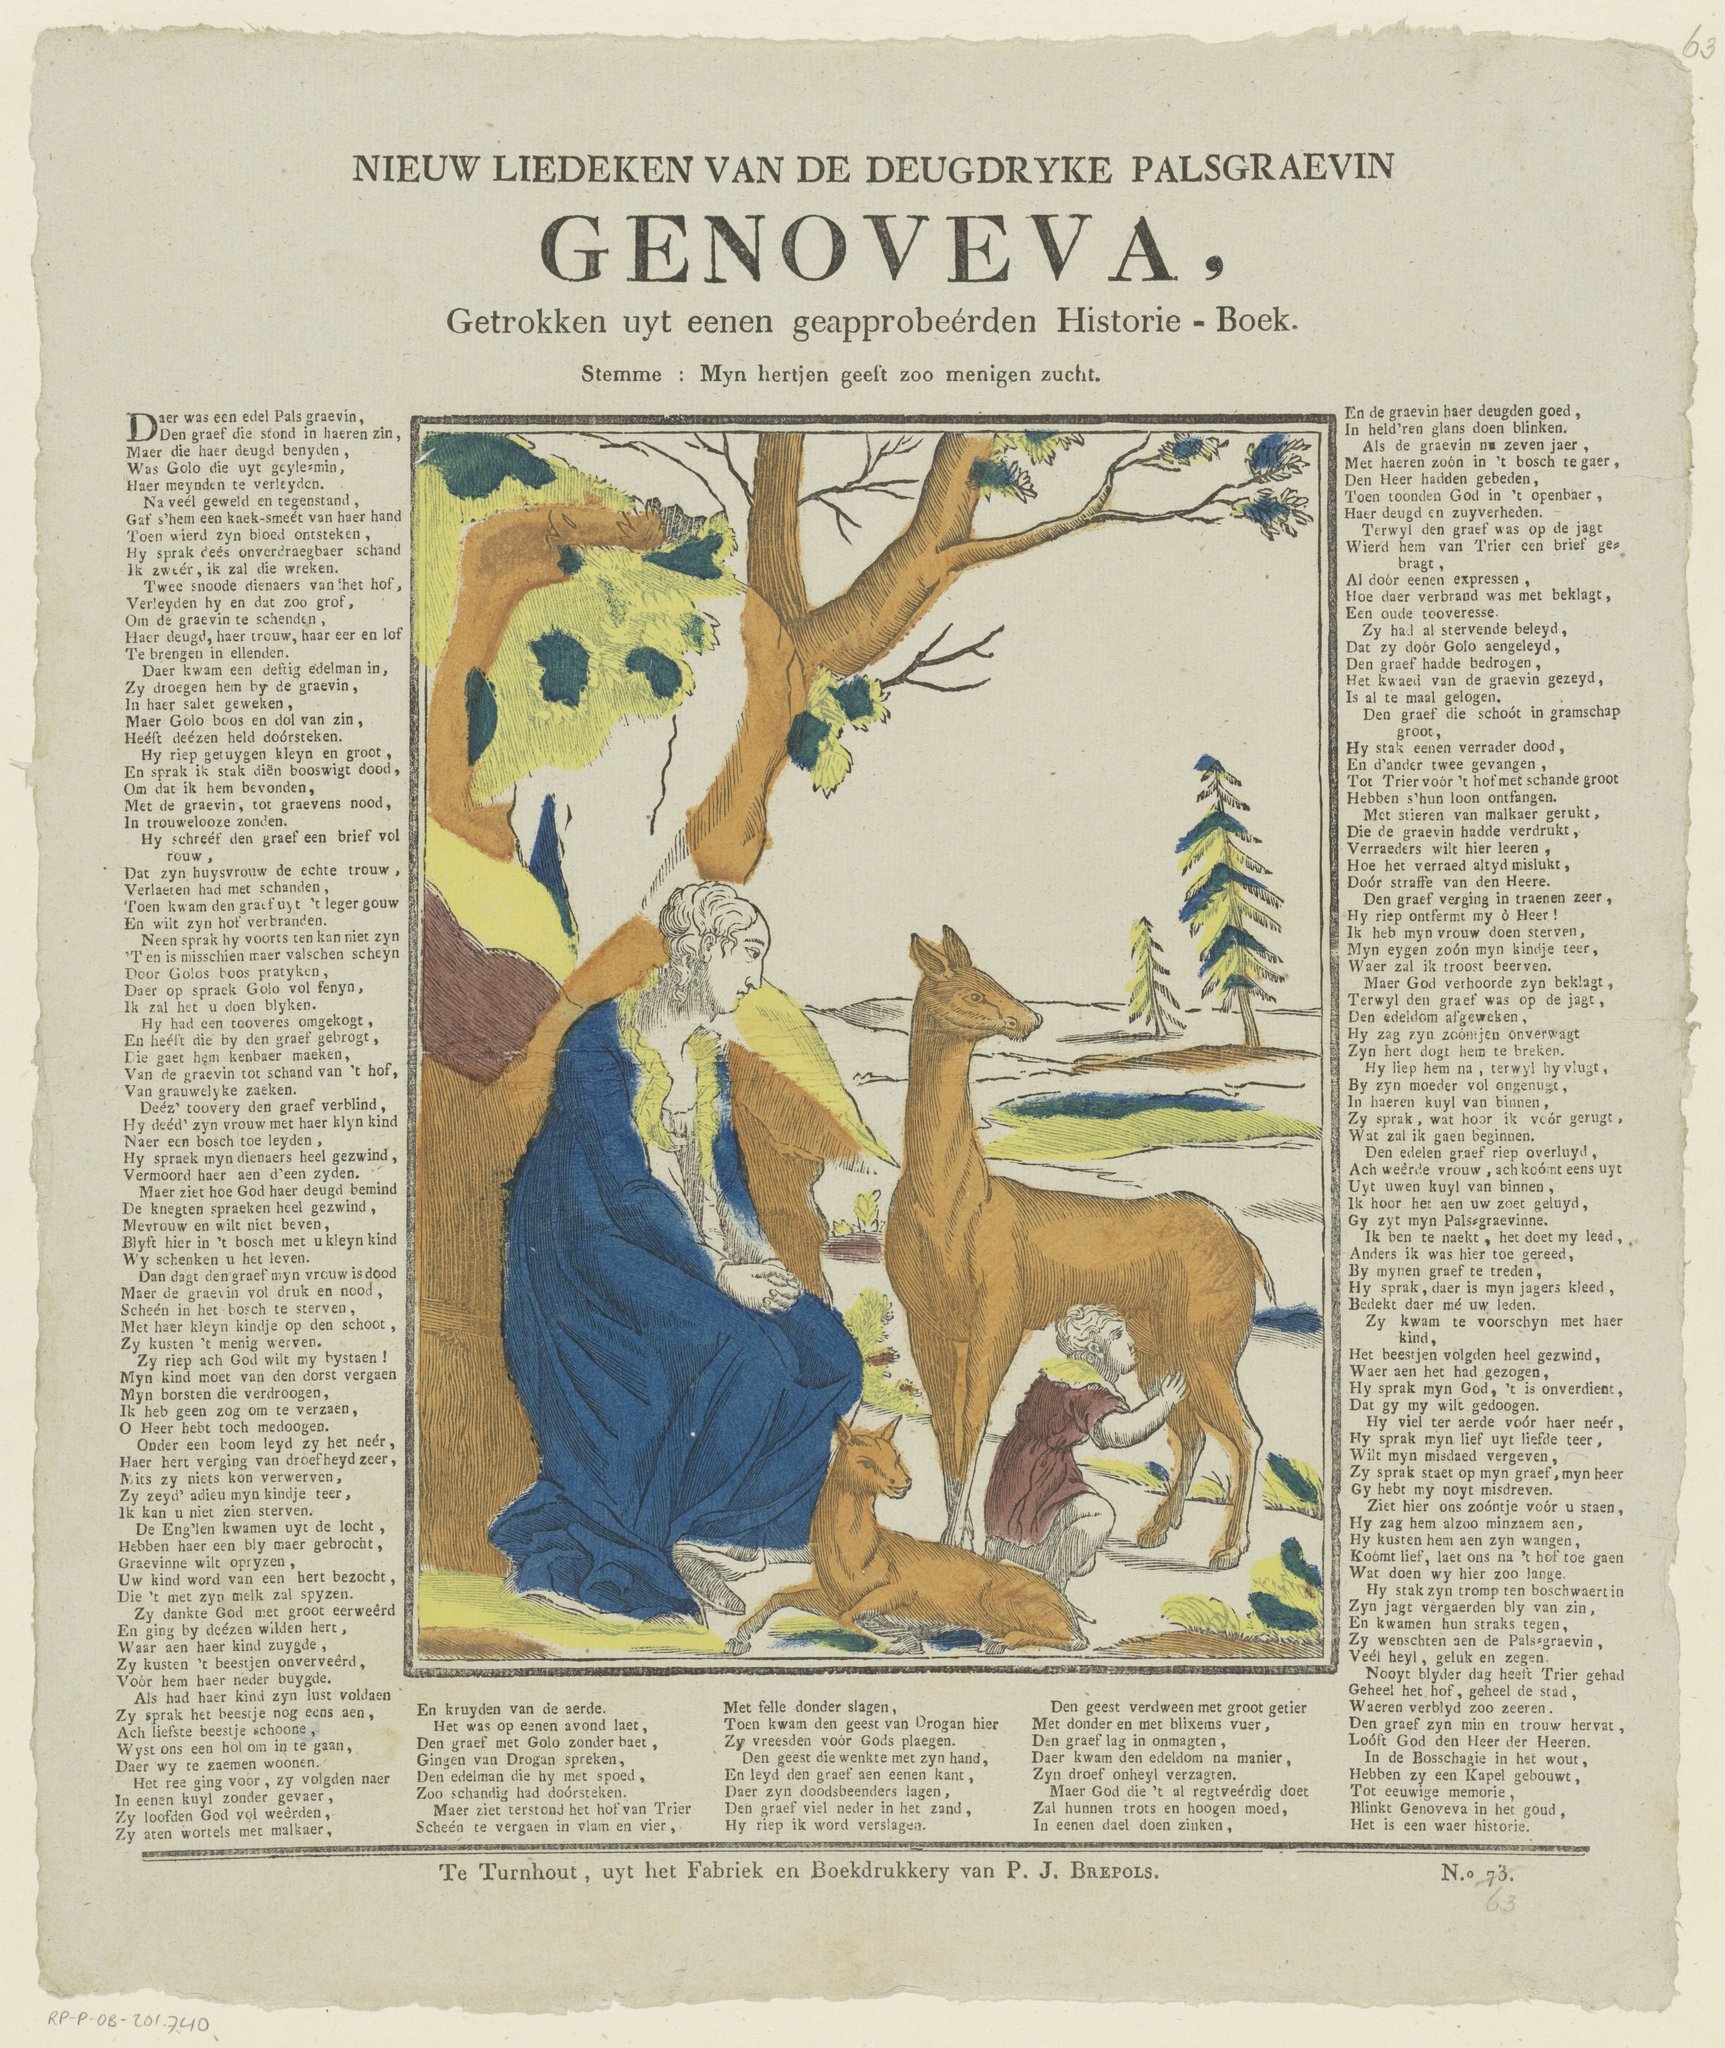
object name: print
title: Nieuw liedeken van de deugdryke palsgraevein / Genoveva, / Getrokken uyt eenen geapprobeérden historie - boek / Stemme: Myn hertjen geeft zoo menigen zucht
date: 1800-1833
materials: paper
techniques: colour, letterpress printing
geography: turnhout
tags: genoveva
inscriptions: collector's mark: Lugt 2760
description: Genoveva van Brabant zittend in de wildernis met haar zoontje. Haar zoontje wordt gezoogd door een ree. Op de voorgrond ligt een jong reetje. Rondom tekst in boekdruk in het Nederlands. Genummerd rechtsonder: No. 73.